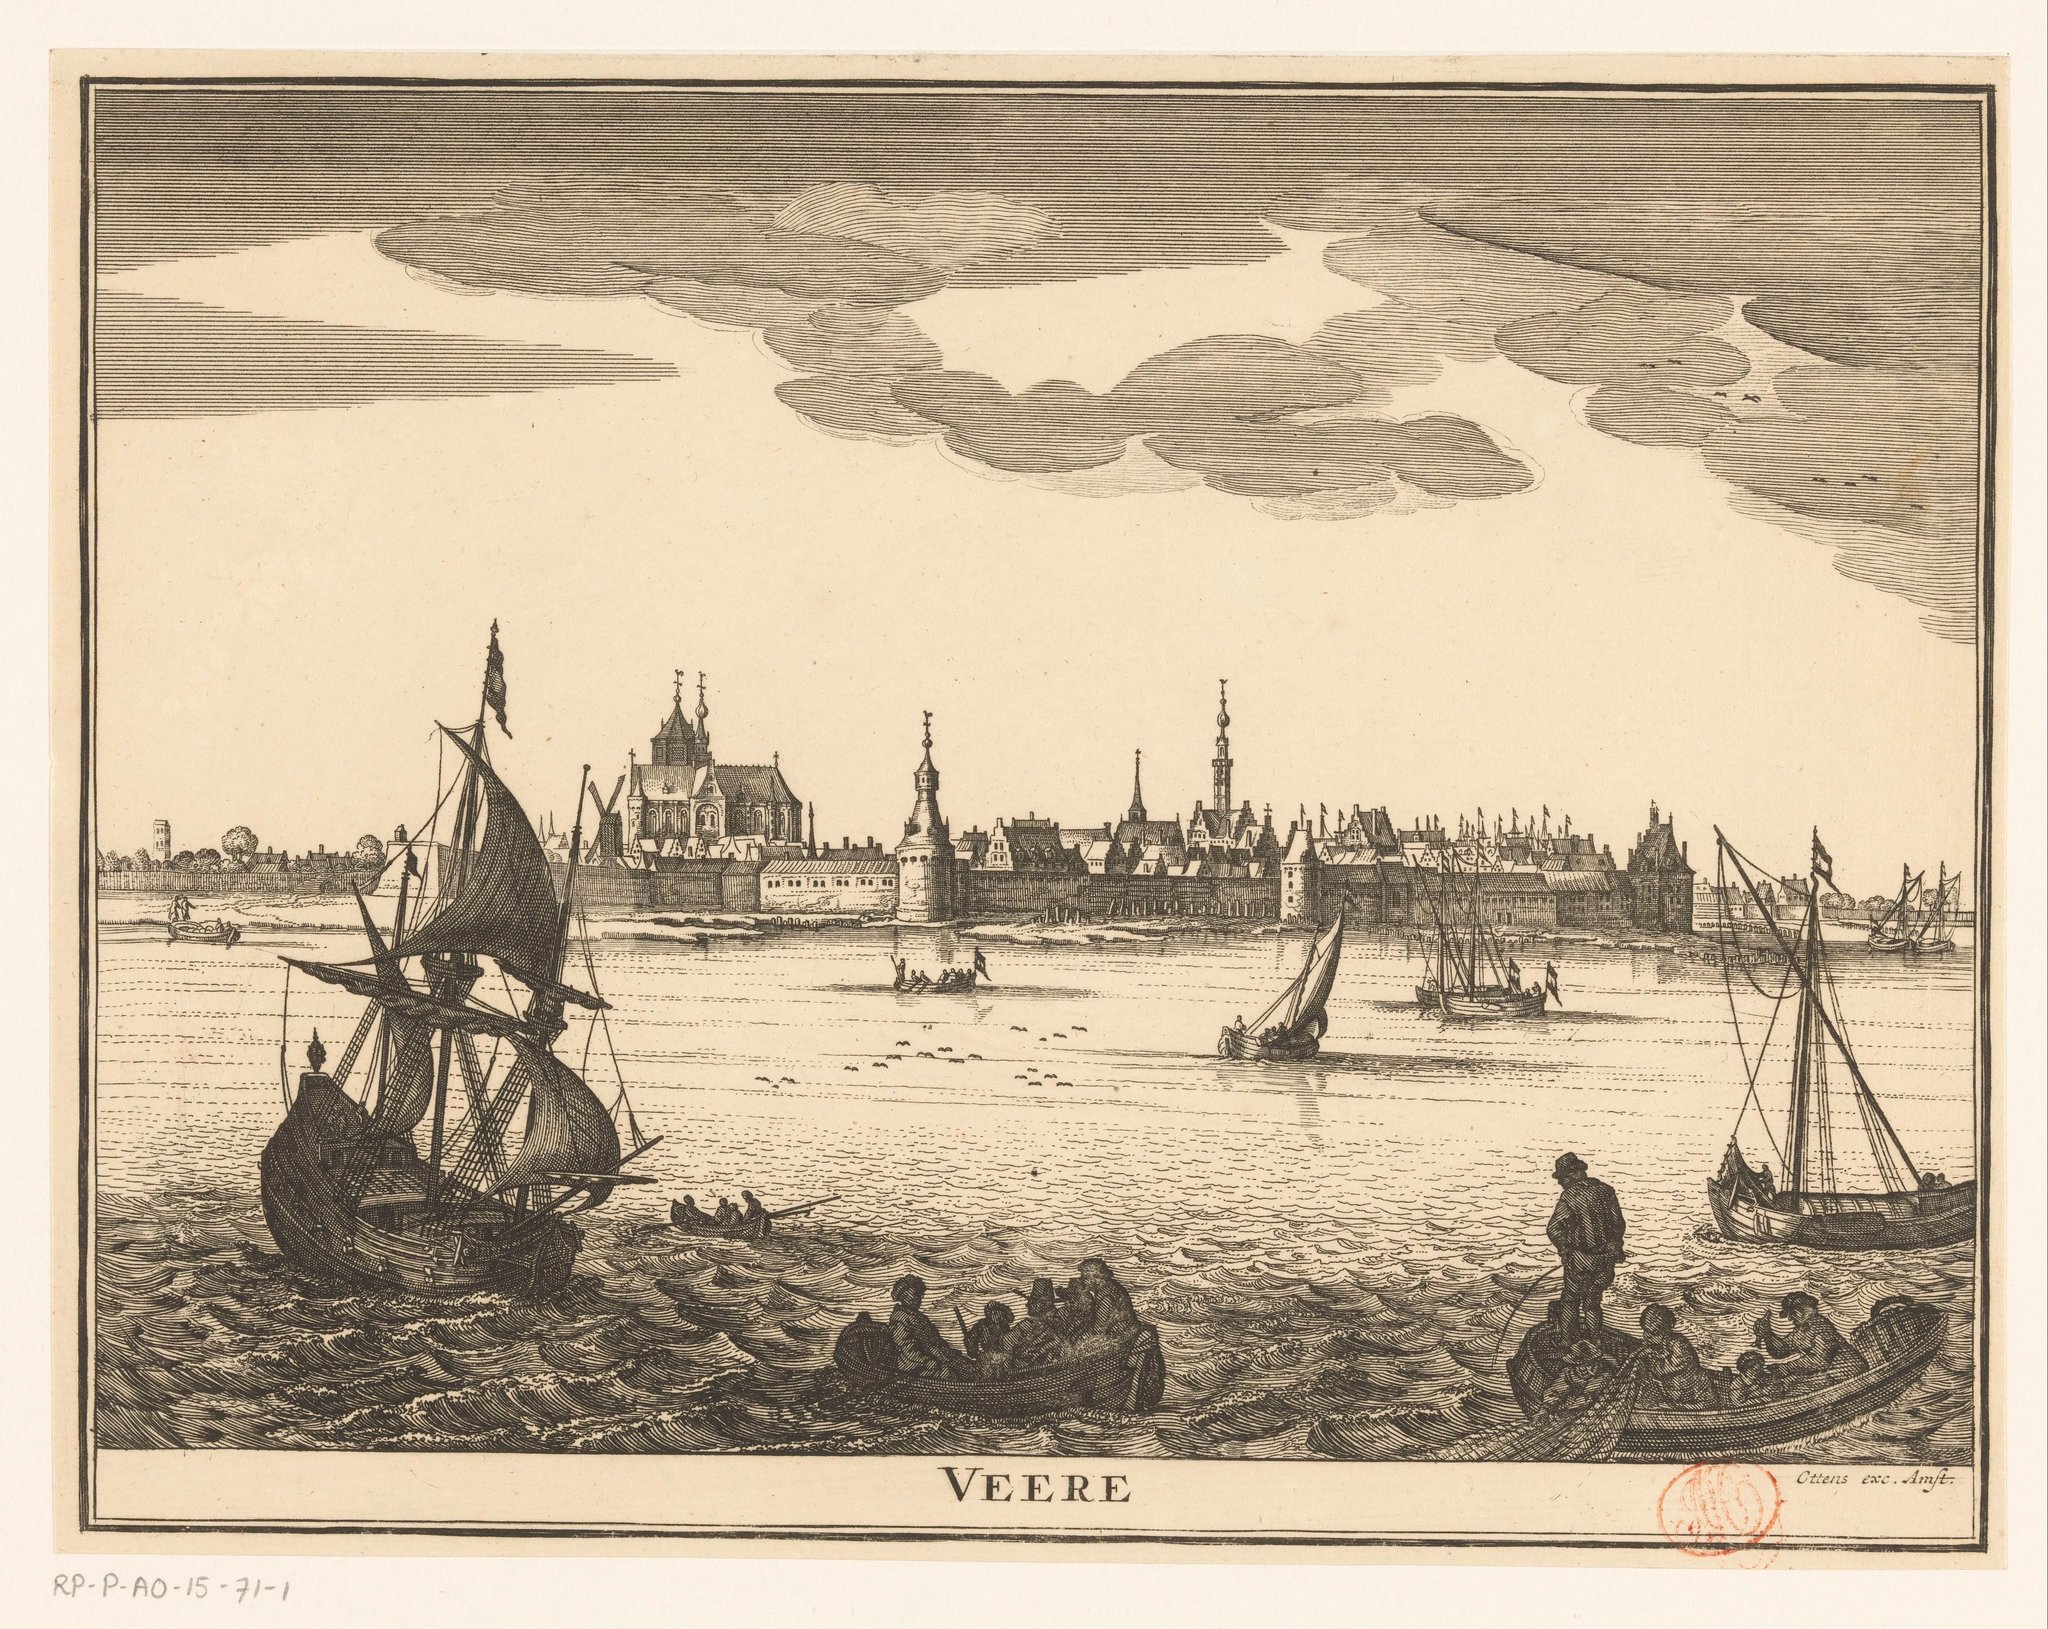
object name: print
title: Gezicht op Veere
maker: pieter hendricksz. schut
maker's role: print maker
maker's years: 1618-1660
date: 1656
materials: paper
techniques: engraving, etching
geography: amsterdam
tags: sailing-ship, sailing-boat, church (exterior), rowing-boat, canoe, etc., prospect of city, town panorama, silhouette of city, fisherman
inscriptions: collector's mark: Lugt 195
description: Prent ook gebruikt in: Speculum Zelandiae dat is een beschryvinge ofte afbeelding der steden, ambachts-heerlijckheden, dorpen castelen, ridderlijcke hofsteden, huysen en gebouwen gelegen inde eylanden en de graeflijckheyt van Zeelandt. Amsterdam: weduwe Ottens en Zoonen, s.a. [1719-1725]. Eerdere staat/staten van prent is/zijn gebruikt in eerdere uitgaven van 'Speculum Zelandiae' en in andere publicaties uitgegeven door Zacharias Roman en Nicolaes Visscher (I). De eerste publicatie waarin de eerste staat van de huidige prent voorkomt dateert uit 1656. Verwarring rondom de datering kan ontstaan door het feit de prenten uit 'Speculum Zelandiae' ook voorkomen in eerder uitgegeven publicaties, waar ze later in zijn ingebonden. Zo komen prenten uitgegeven door Roman/Visscher voor in sommige exemplaren van: Boxhorn, Marcus Zuerius van. Chroniick van Zeelandt (…). 2 delen. Middelburg: Zacharias Roman, 1644. De door weduwe (Joachim) Ottens en Zoonen uitgegeven prenten zijn later ingebonden in sommige exemplaren van: Smallegange, Mattheus. Nieuwe Cronyk van Zeeland (…). Middelburg en Amsterdam: Johannes Meertens en Abraham van Someren, 1696. Zie RP-P-AO-15-71-2 voor eerste staat.